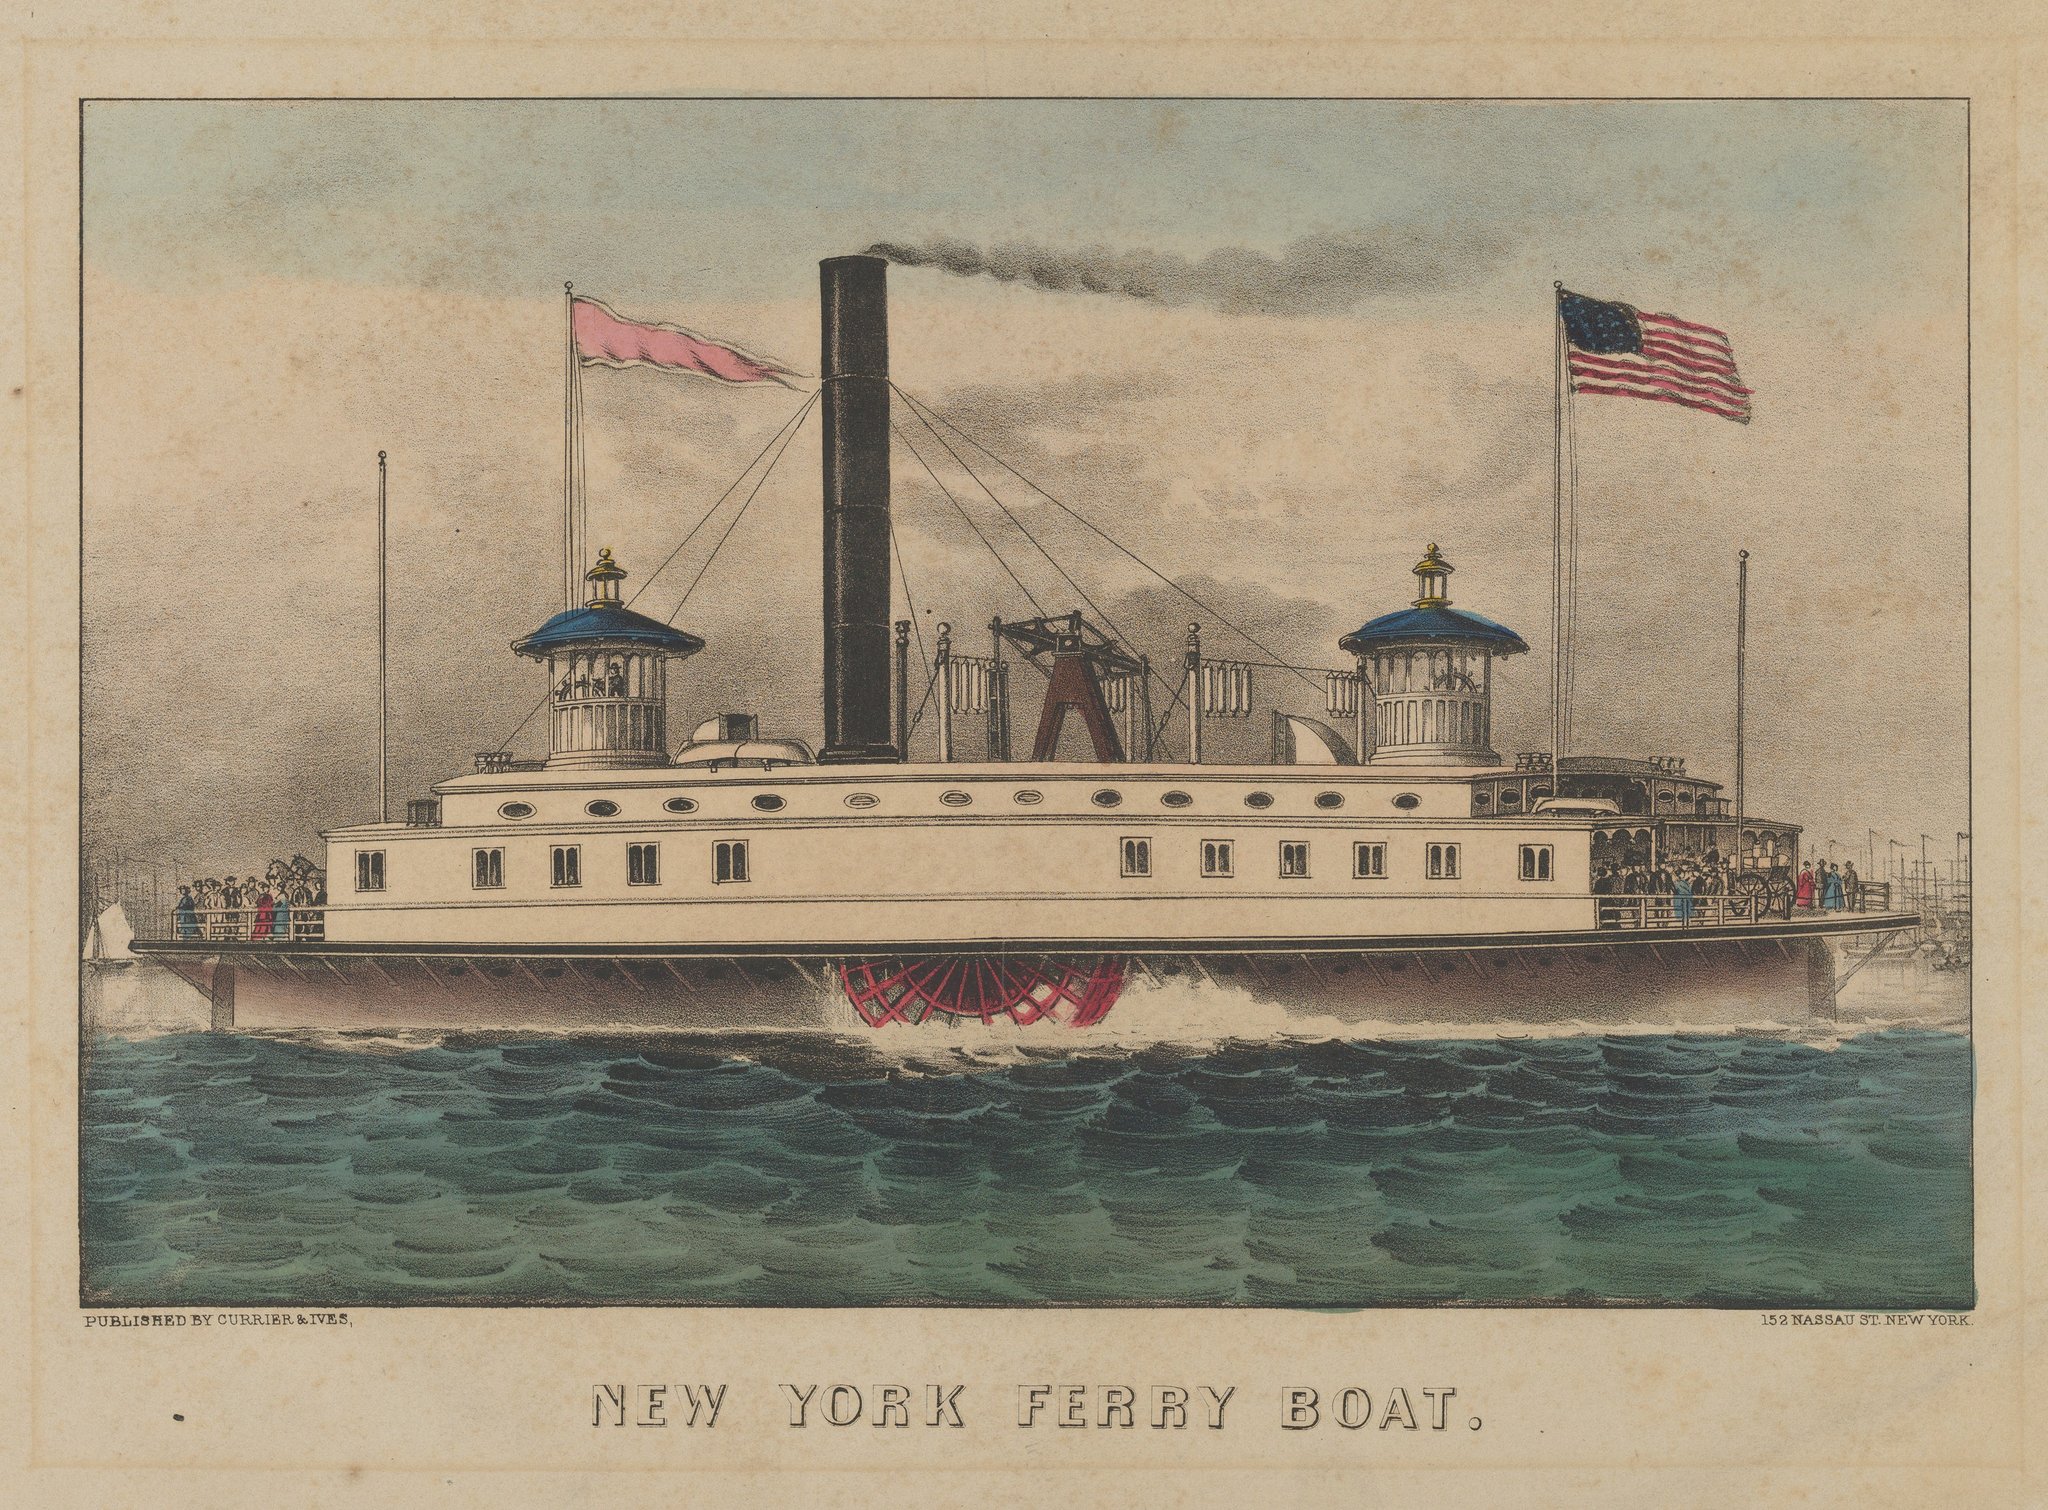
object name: print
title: New York Ferry Boat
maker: currier & ives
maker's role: lithographer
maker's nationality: american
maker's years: 1857-1907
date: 1860-1865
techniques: hand coloring, lithograph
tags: boats